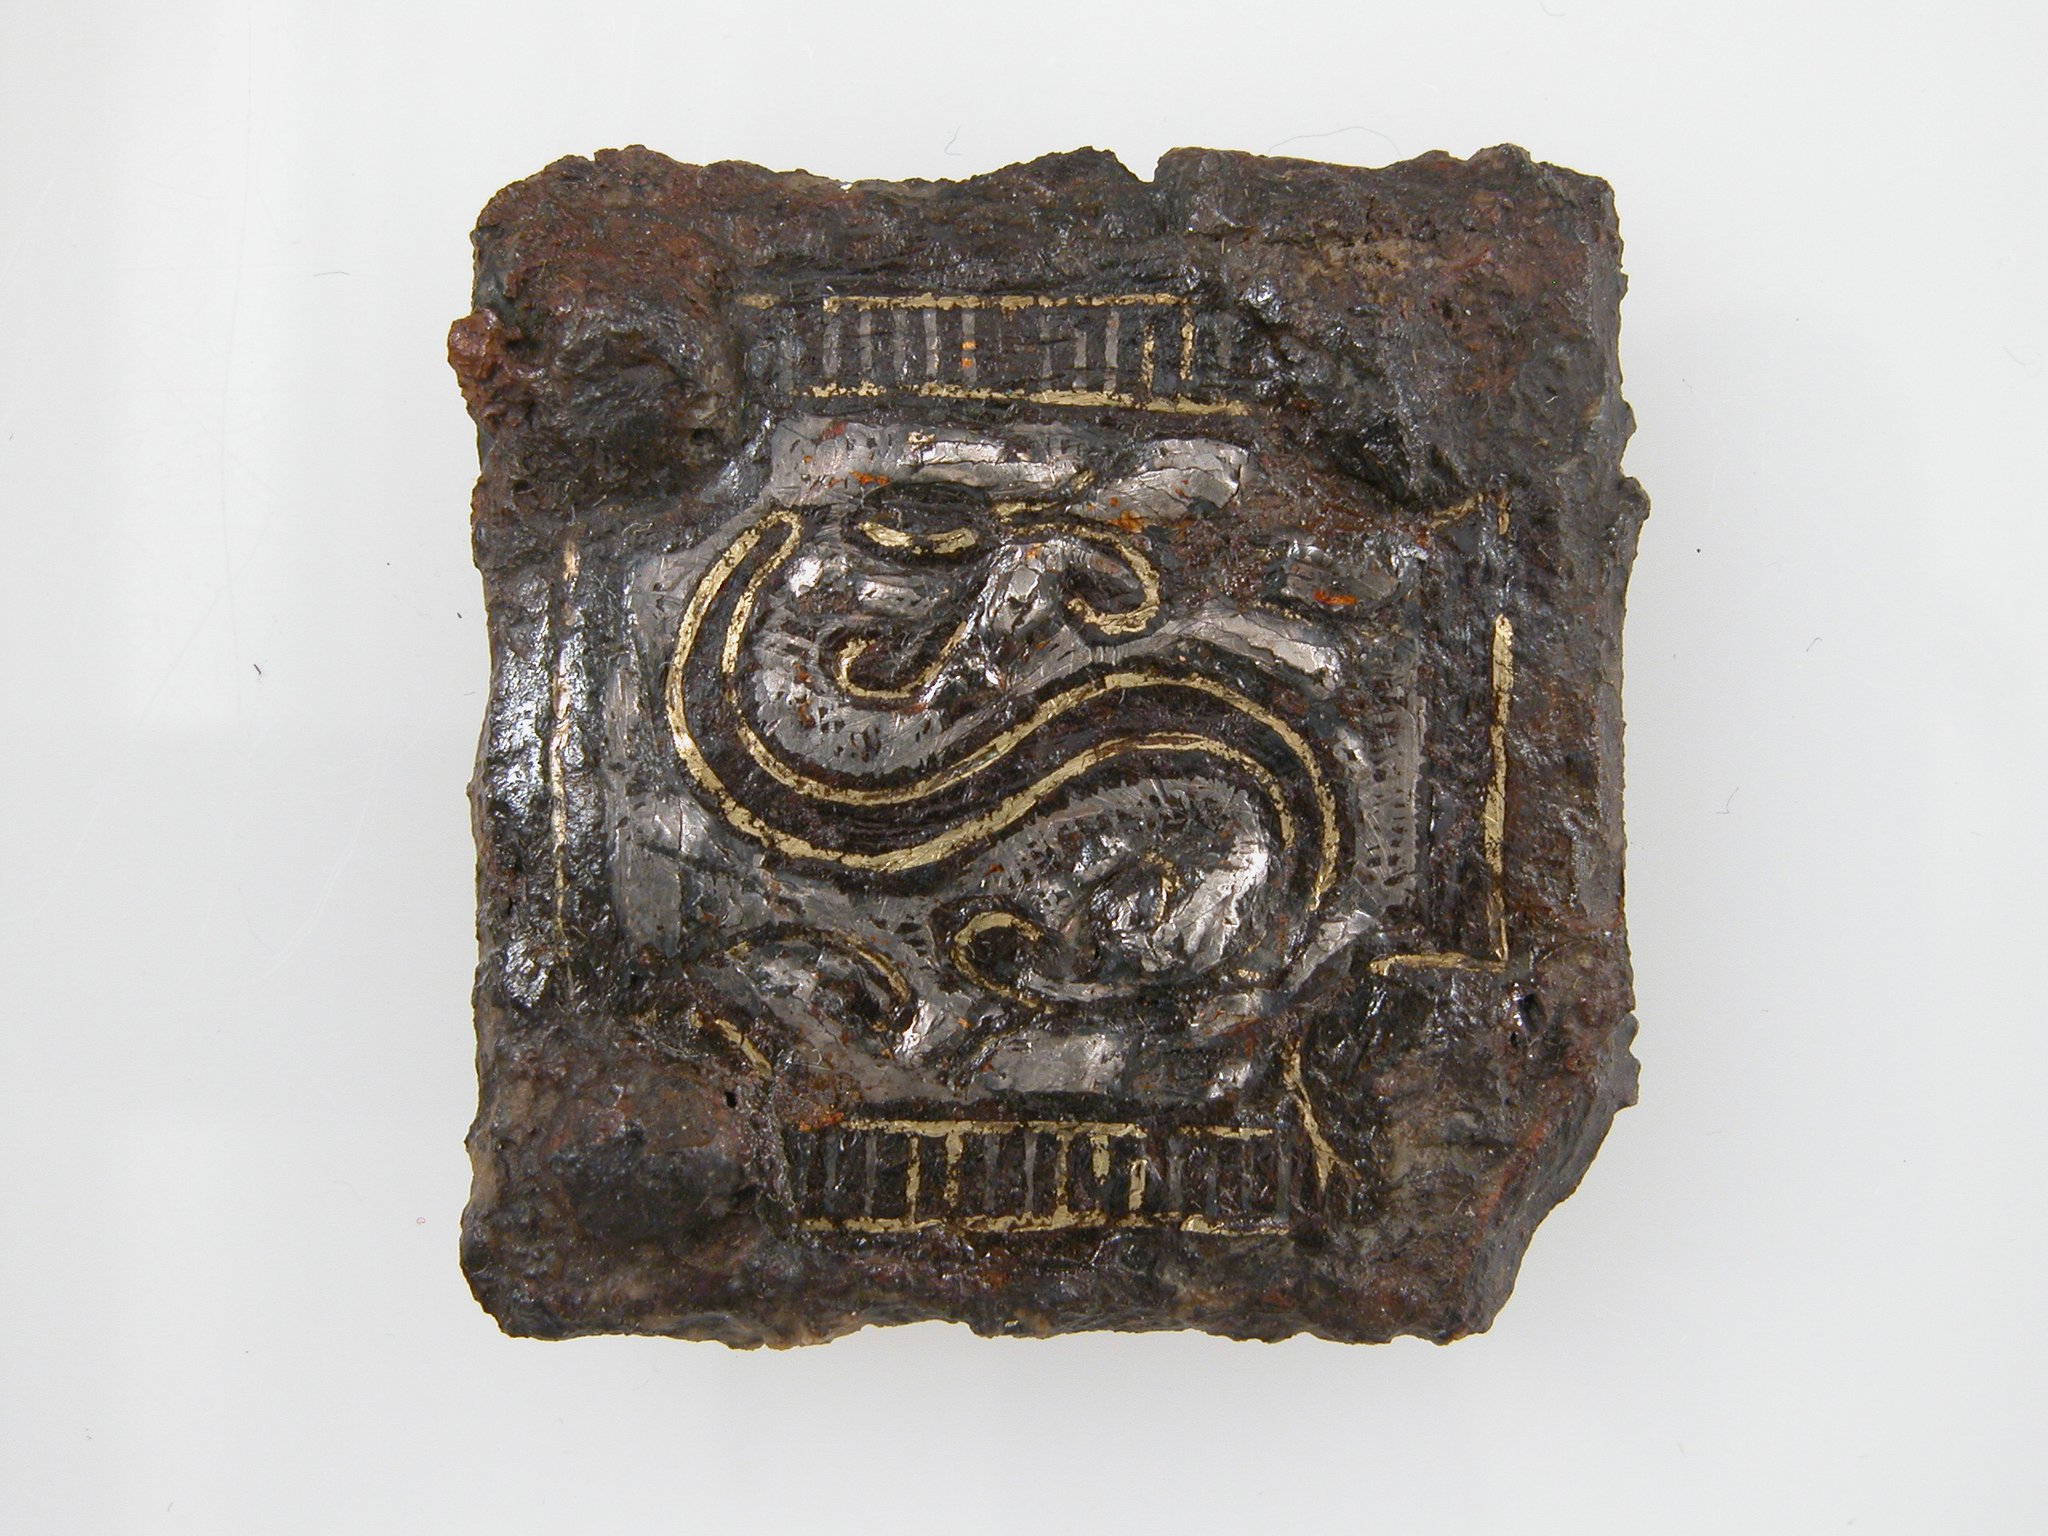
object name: belt plate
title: Belt Buckle Plate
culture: frankish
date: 501-700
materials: brass, iron, silver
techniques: inlay